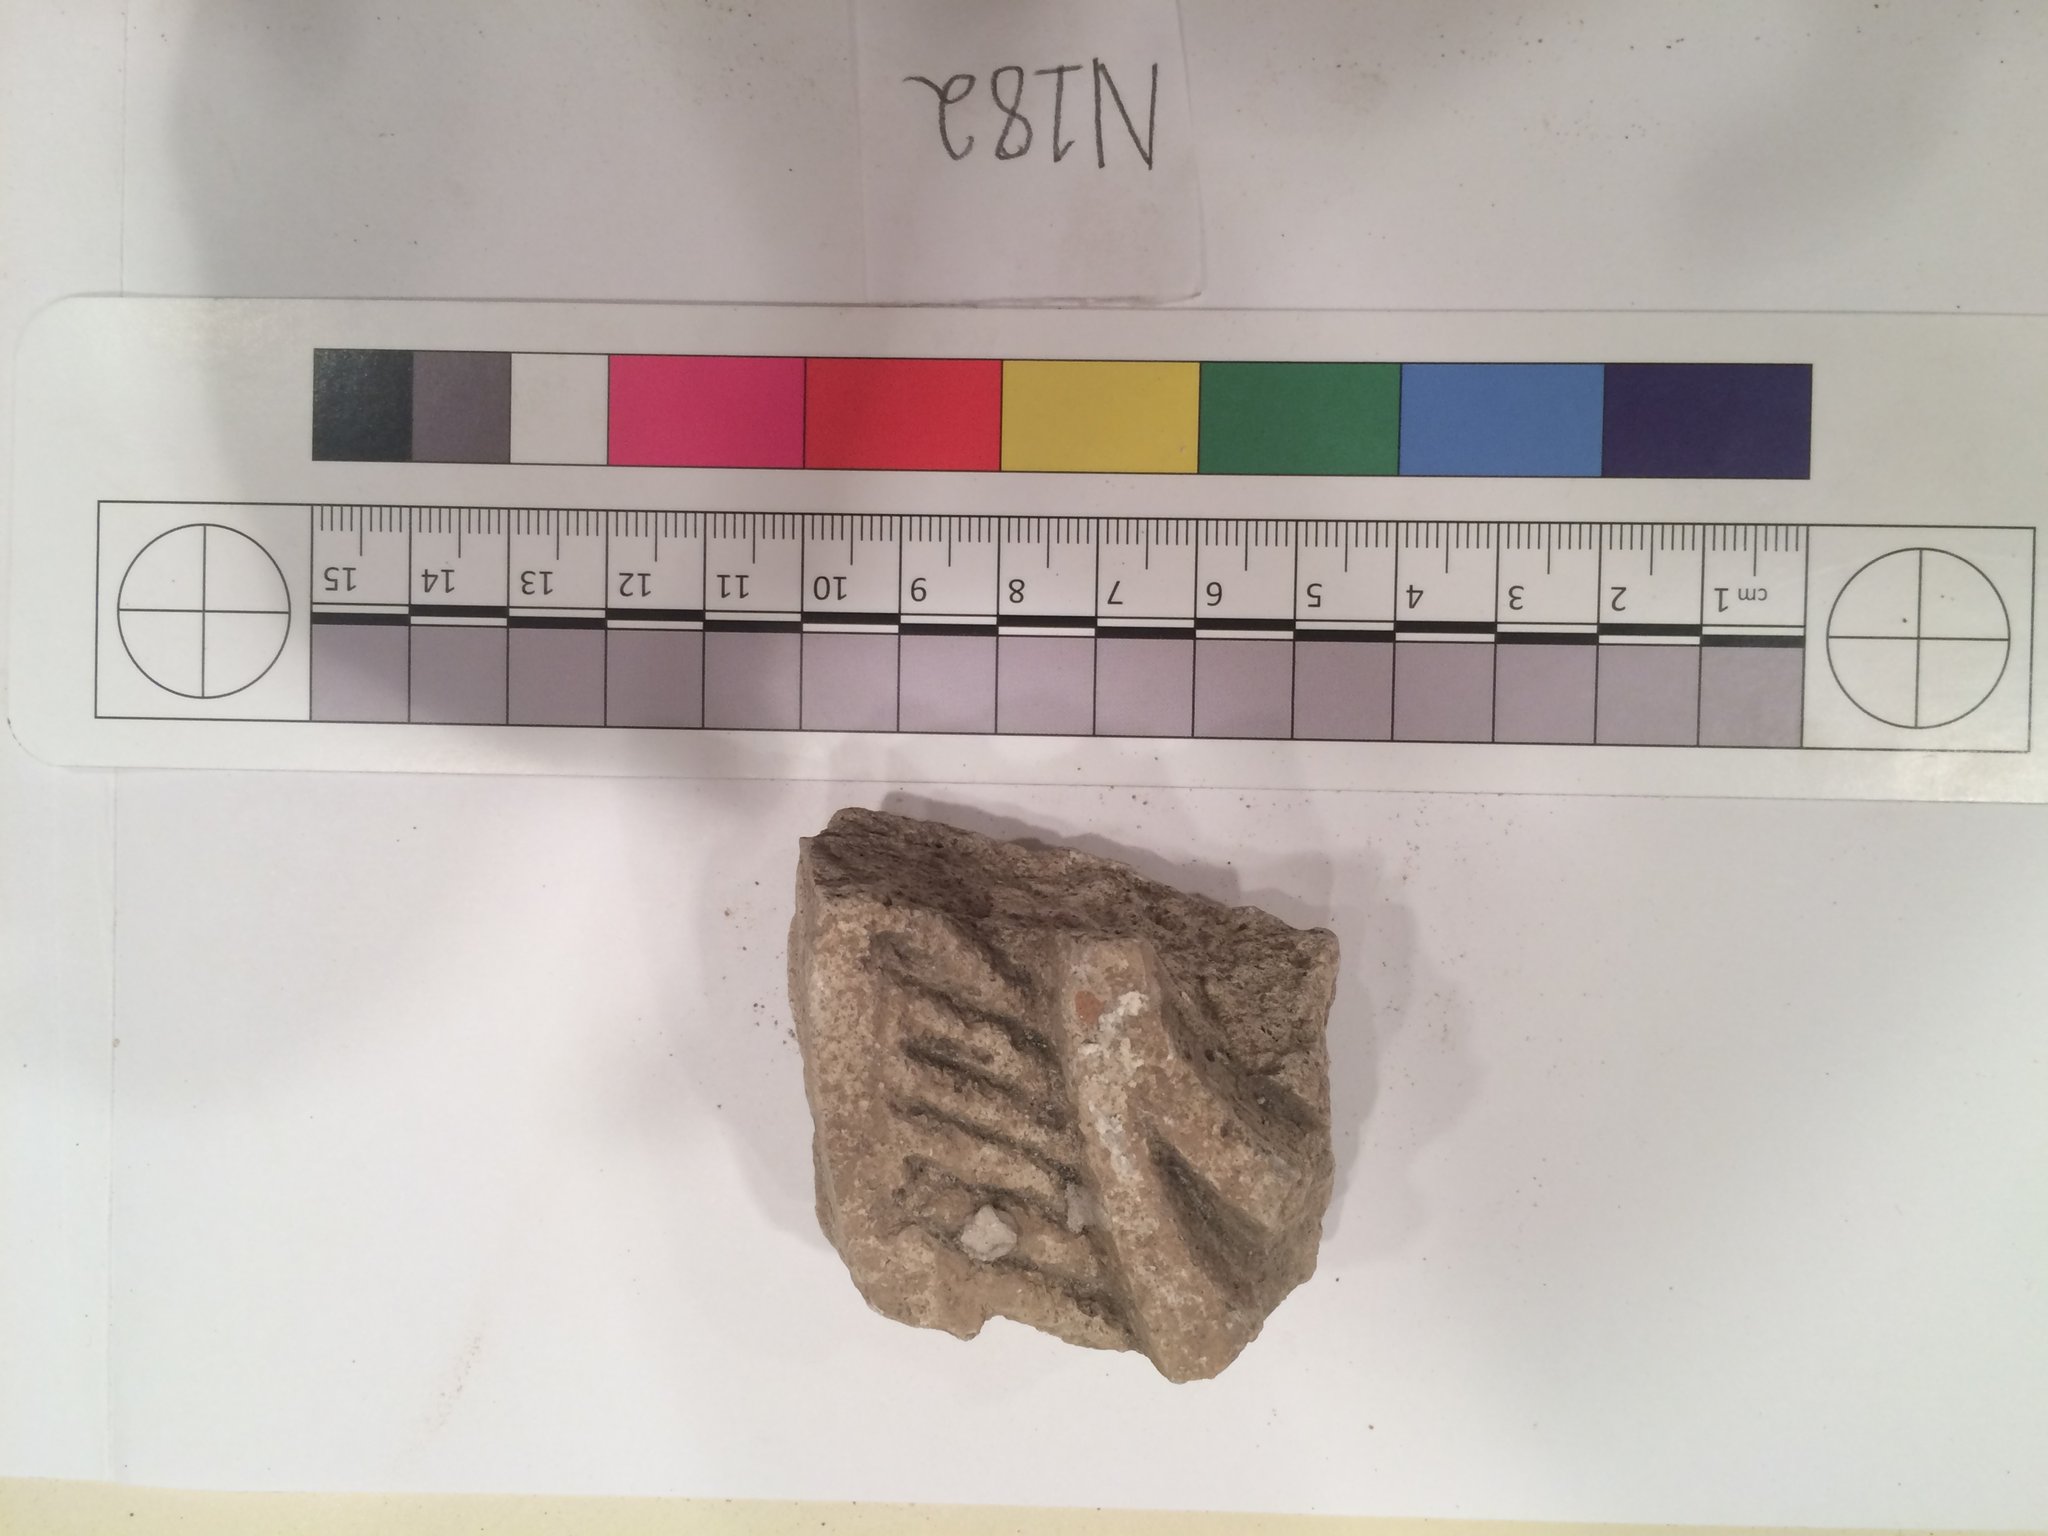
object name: fragment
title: Stucco Fragment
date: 701-1200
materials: plaster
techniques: carving, painting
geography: iran